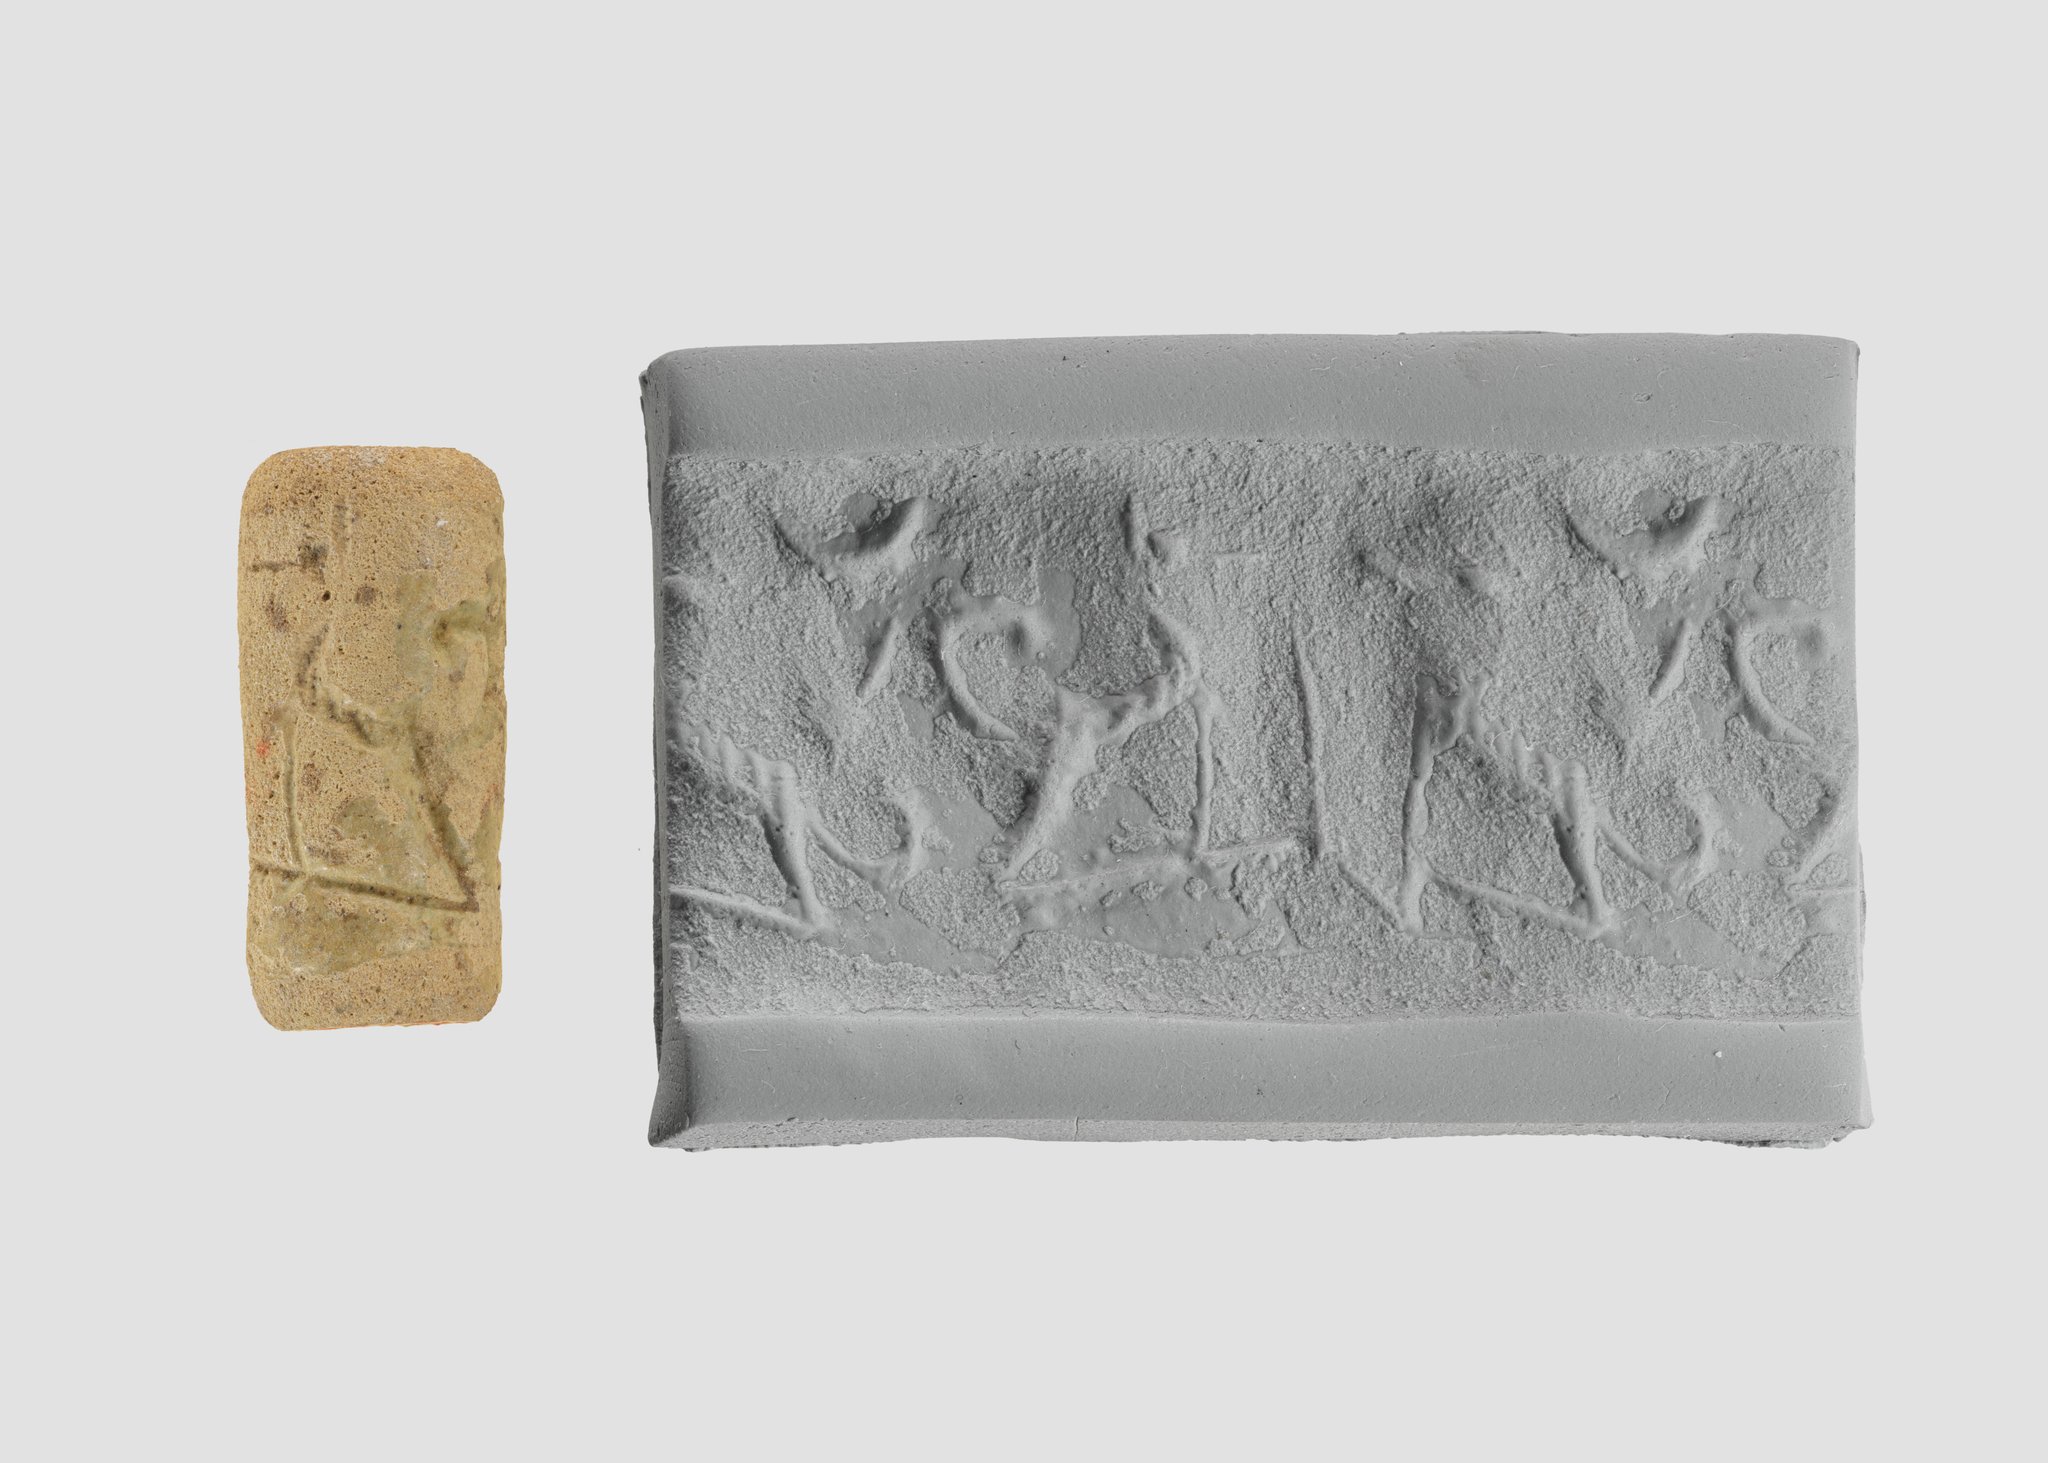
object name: cylinder seal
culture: mitanni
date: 1500-1301 BCE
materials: stone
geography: iran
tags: animals